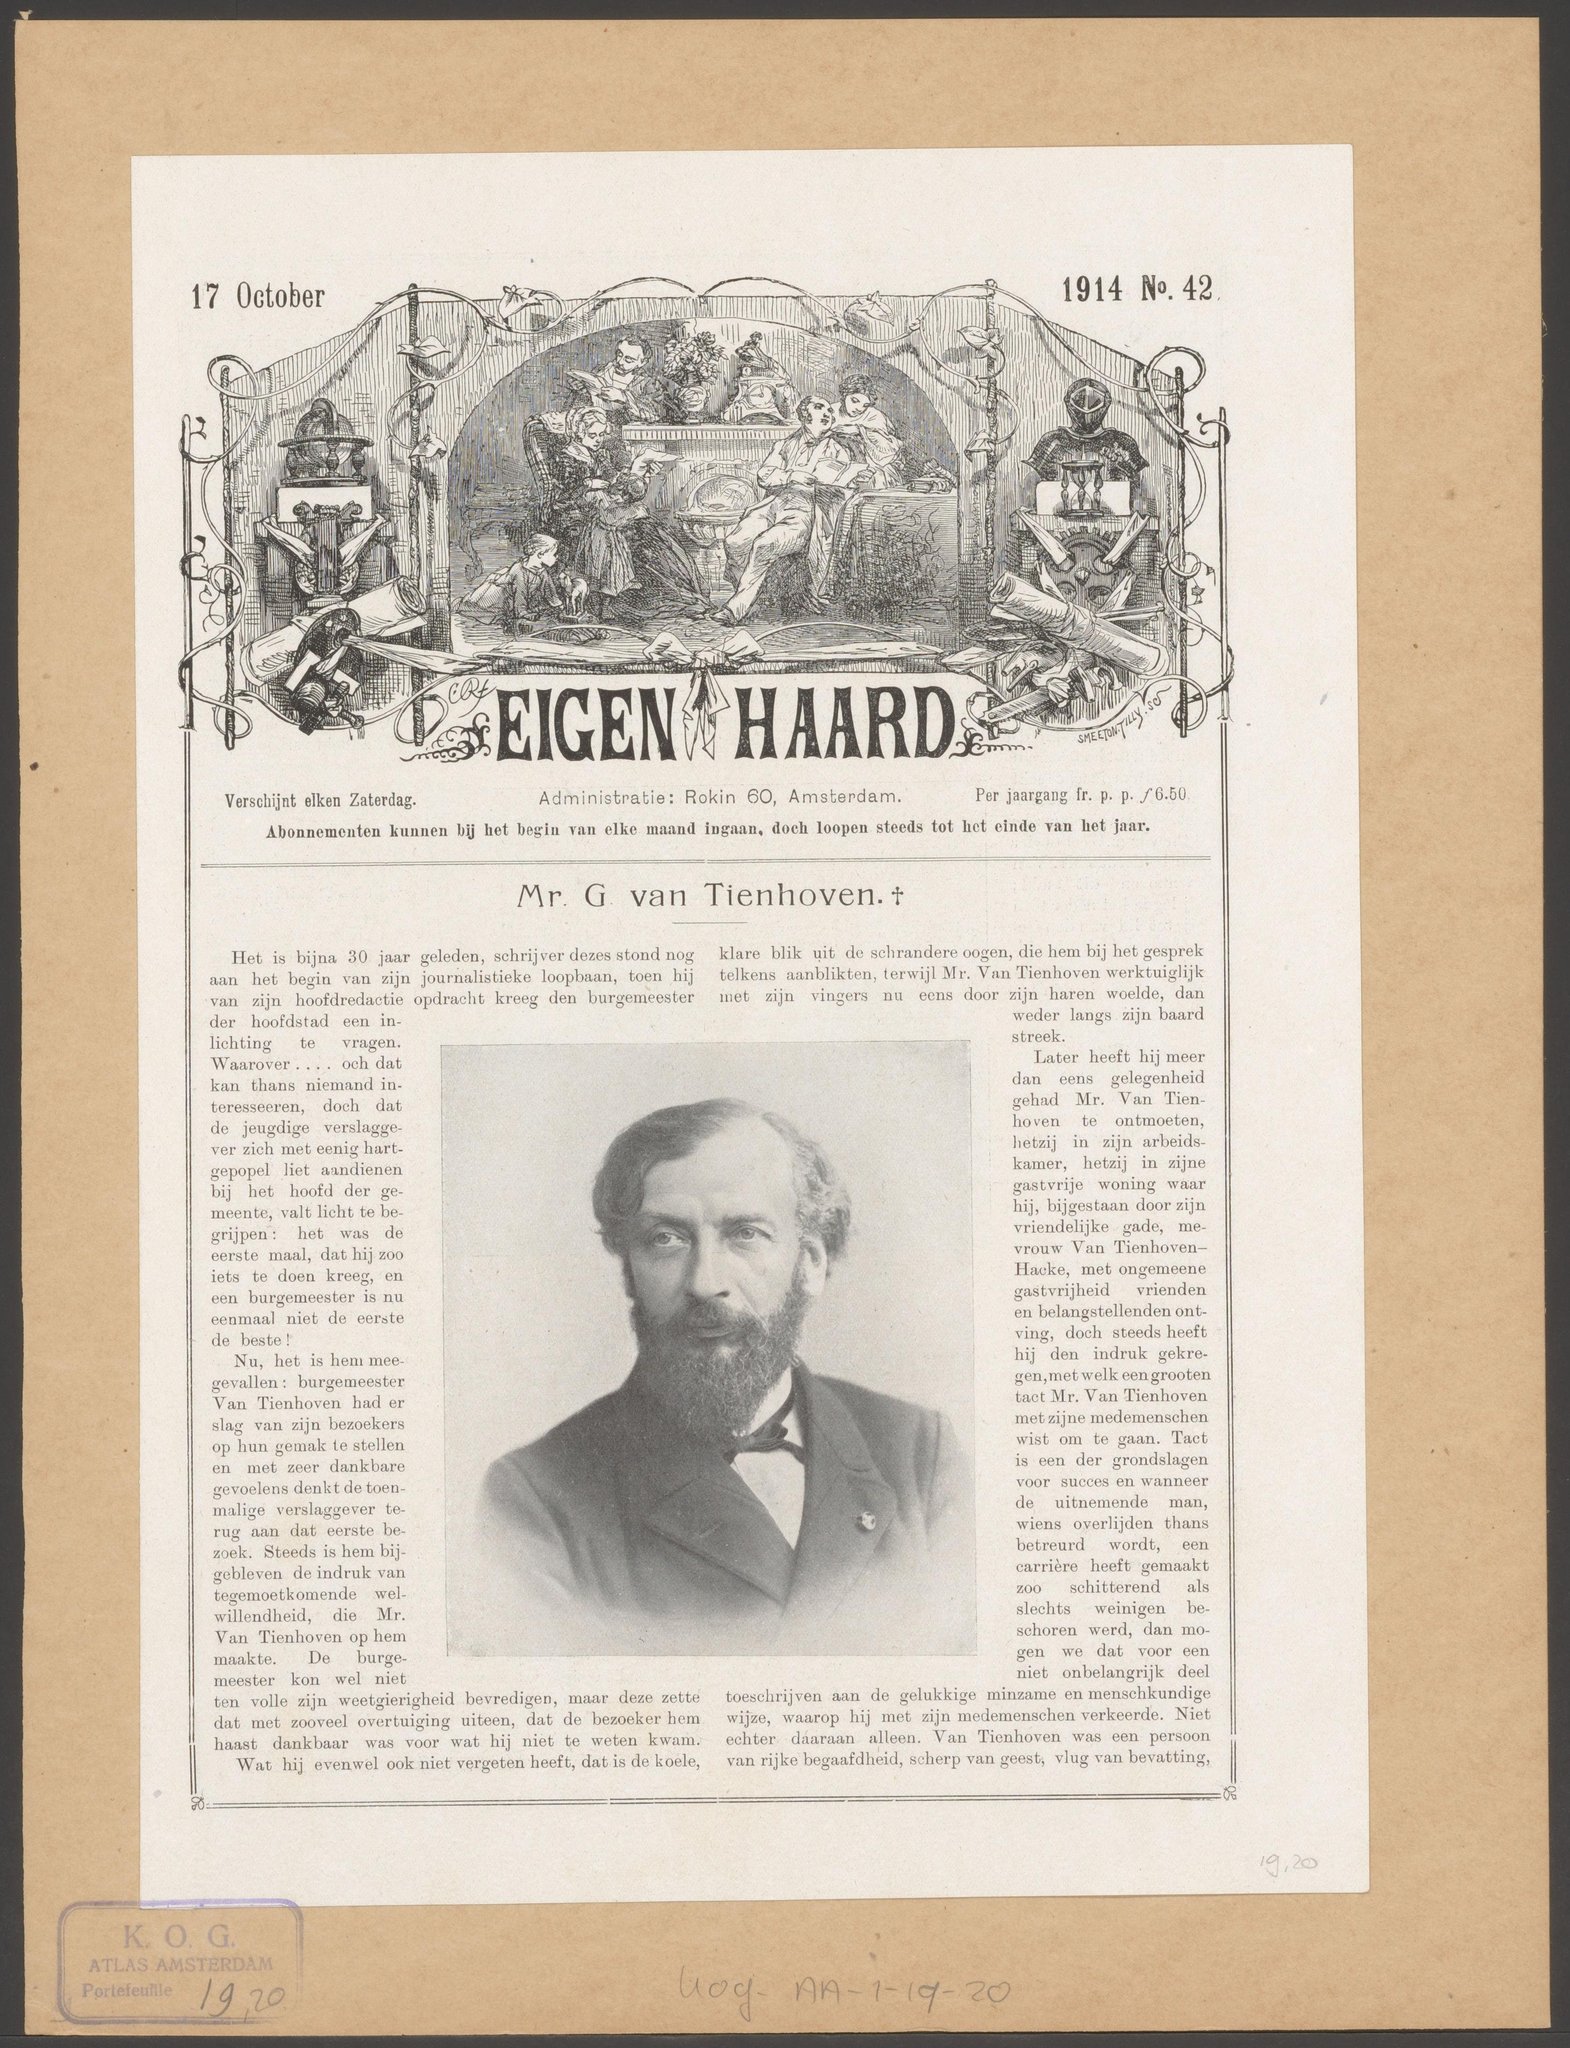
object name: photomechanical print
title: Biografie van Gijsbert van Tienhoven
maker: Anonymous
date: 1914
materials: paper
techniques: letterpress printing, line block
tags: gijsbert van tienhoven, politician, e.g. party leader, amsterdam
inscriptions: collector's mark: ‘19,20’ Lugt 1641b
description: Onderwerpsrubriek binnen de Atlas Amsterdam: Herinneringen aan regeringsleden en hunne huisgezinnen [na 1800].